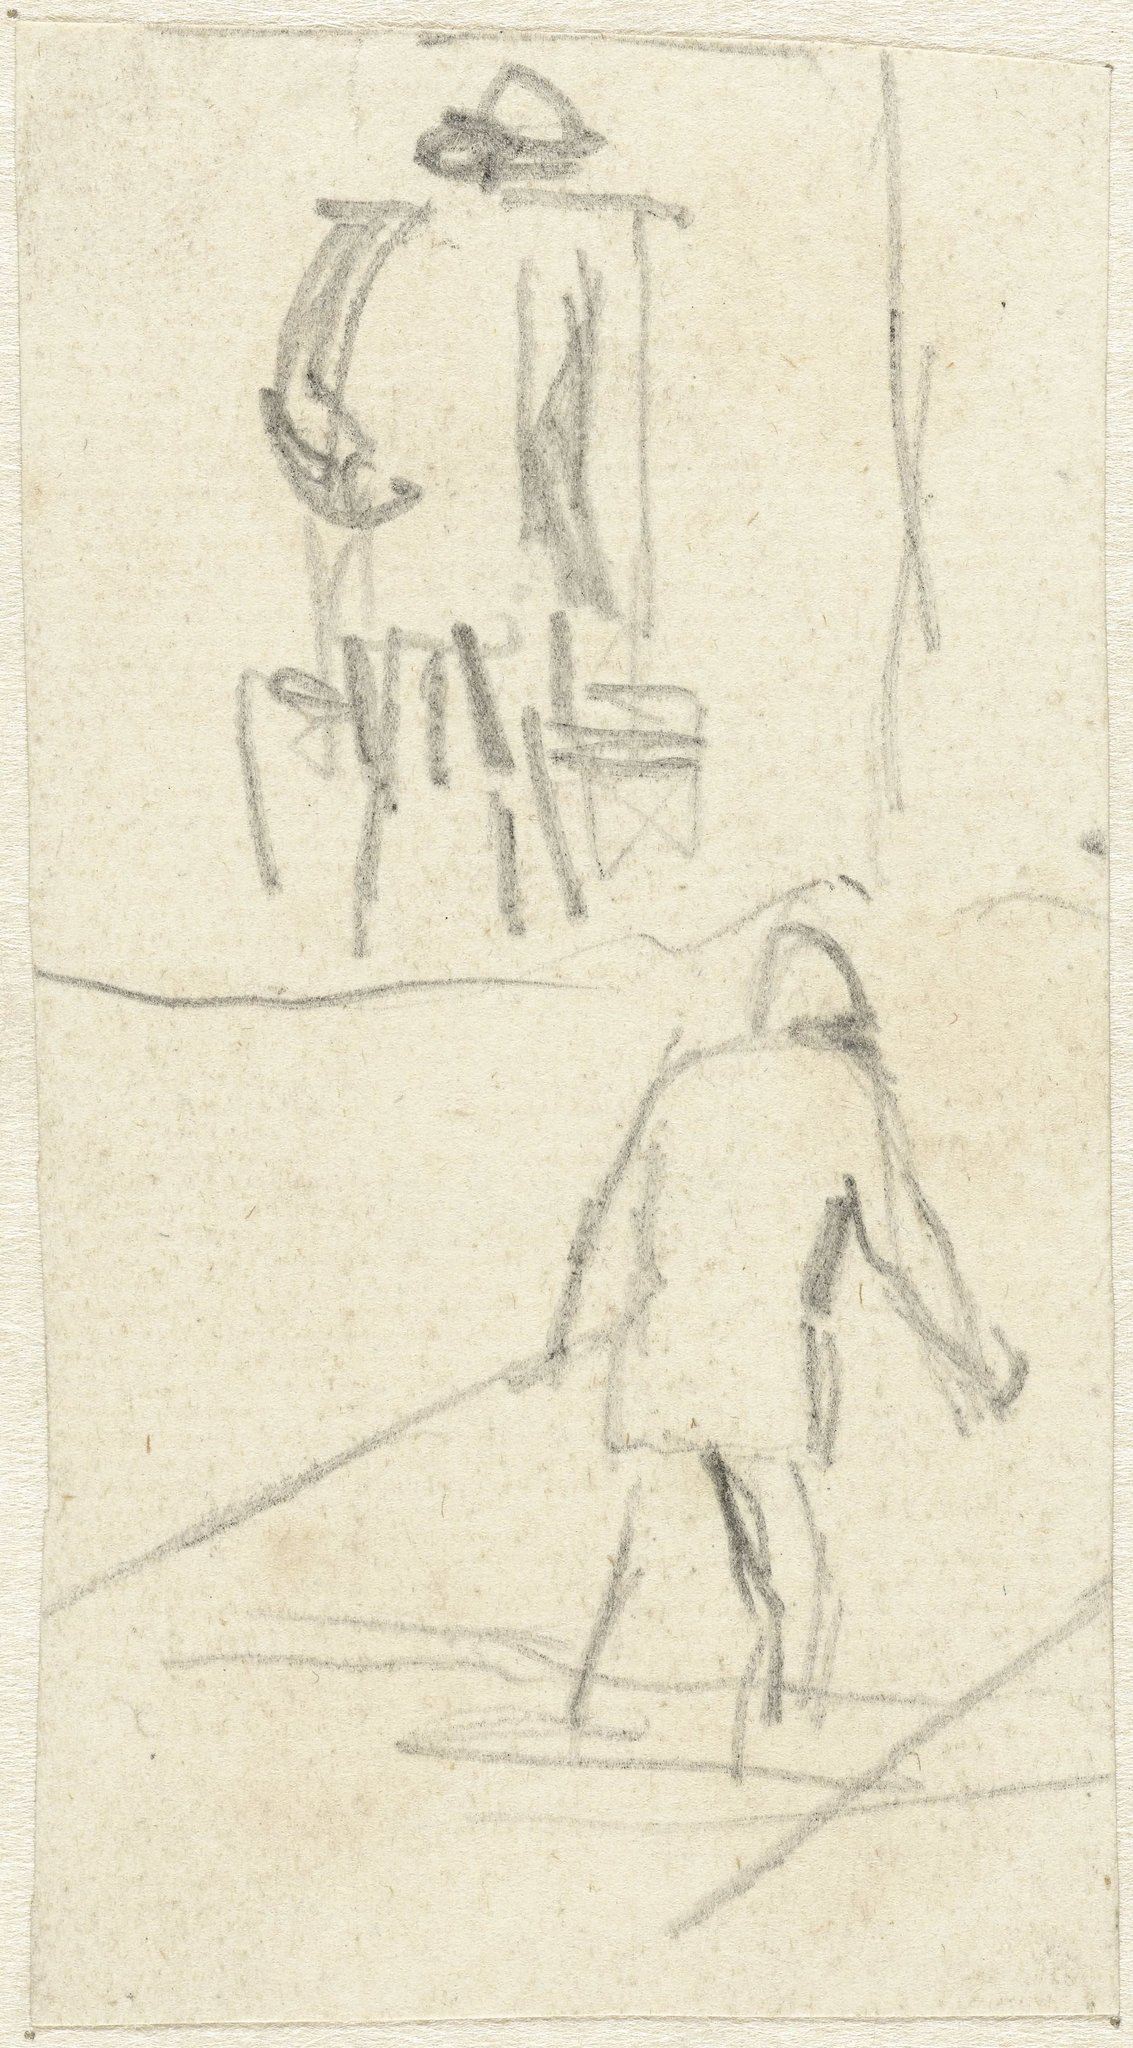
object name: drawing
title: Twee schetsen van dragers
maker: simon andreas krausz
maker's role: draughtsman, print maker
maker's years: 1760-1825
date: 1770-1825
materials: paper, pencil